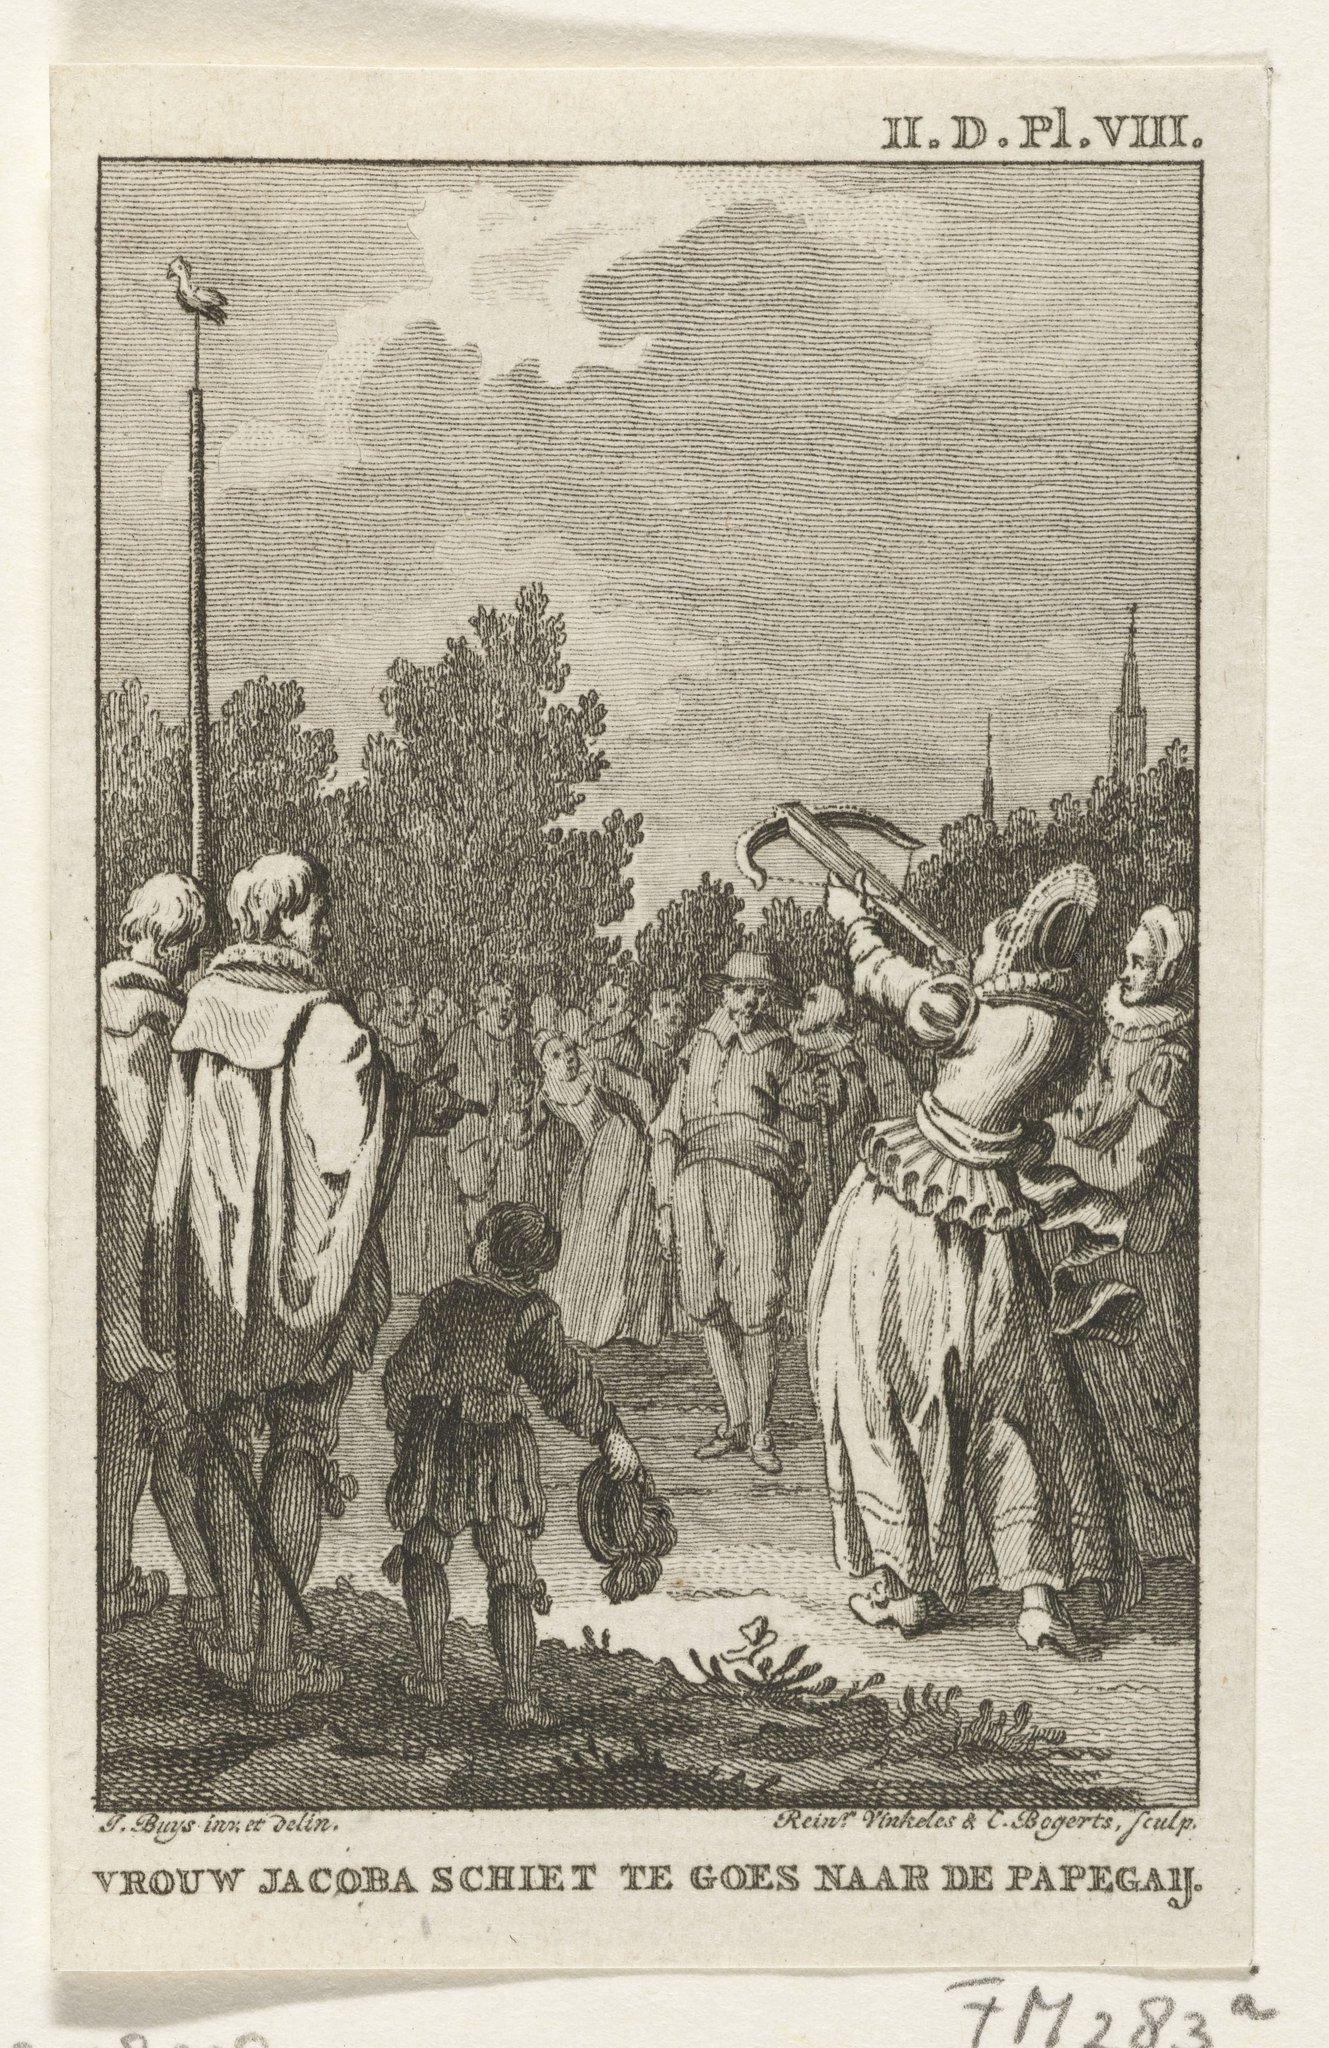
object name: print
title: Jacoba van Beieren schiet te Goes naar de papegaai, ca. 1430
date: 1780-1795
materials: paper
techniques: etching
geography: netherlands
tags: jacoba of bavaria (countess of hainaut), shooting-the-bird (on a high pole), burgundian netherlands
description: Illustratie voor: J. Fokke, Geschiedenissen der Vereenigde Nederlanden voor de vaderlandsche jeugd, Johannes Allart, Amsterdam 1783-1795, 25 delen, dl. II, pl. VIII. Staat met de letter.